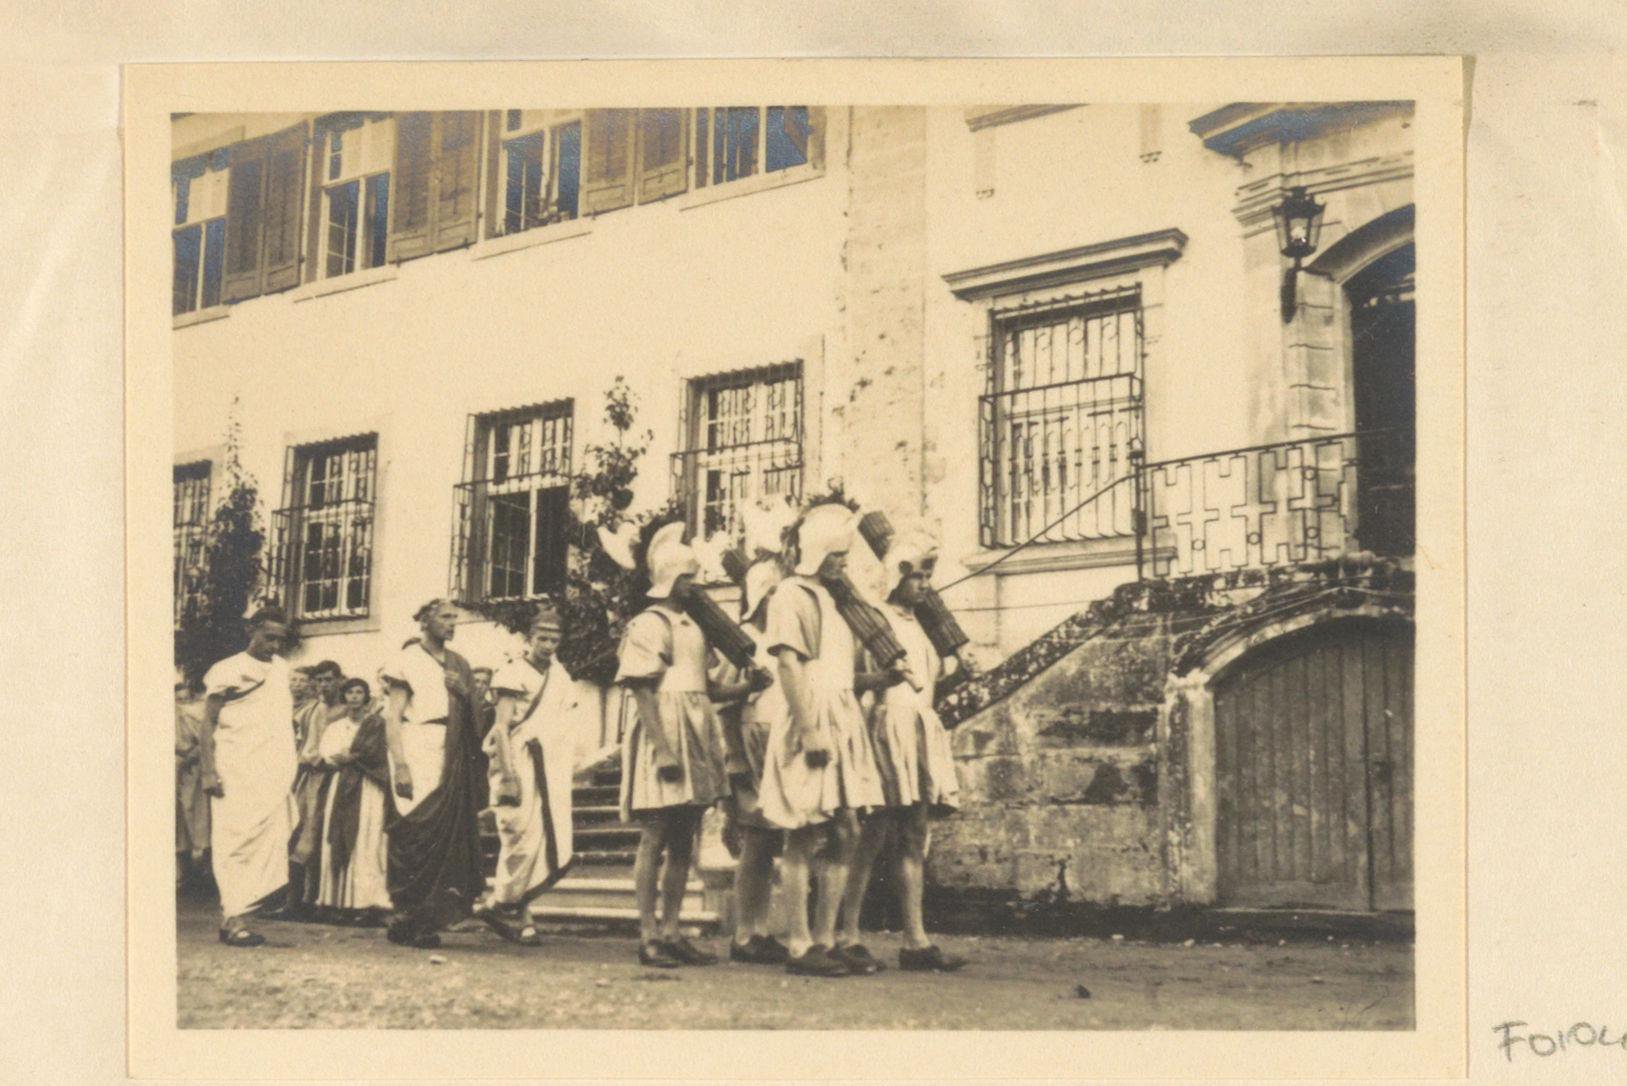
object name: photograph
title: Leerlingen van Schule Schloss Salem tijdens een dramatische uitvoering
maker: Anonymous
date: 1929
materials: photographic support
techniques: gelatin silver print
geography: salem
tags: performance, theatre, theatrical performance, historical costume, education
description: Onderdeel van Fotoalbum van Schule Schloss Salem.